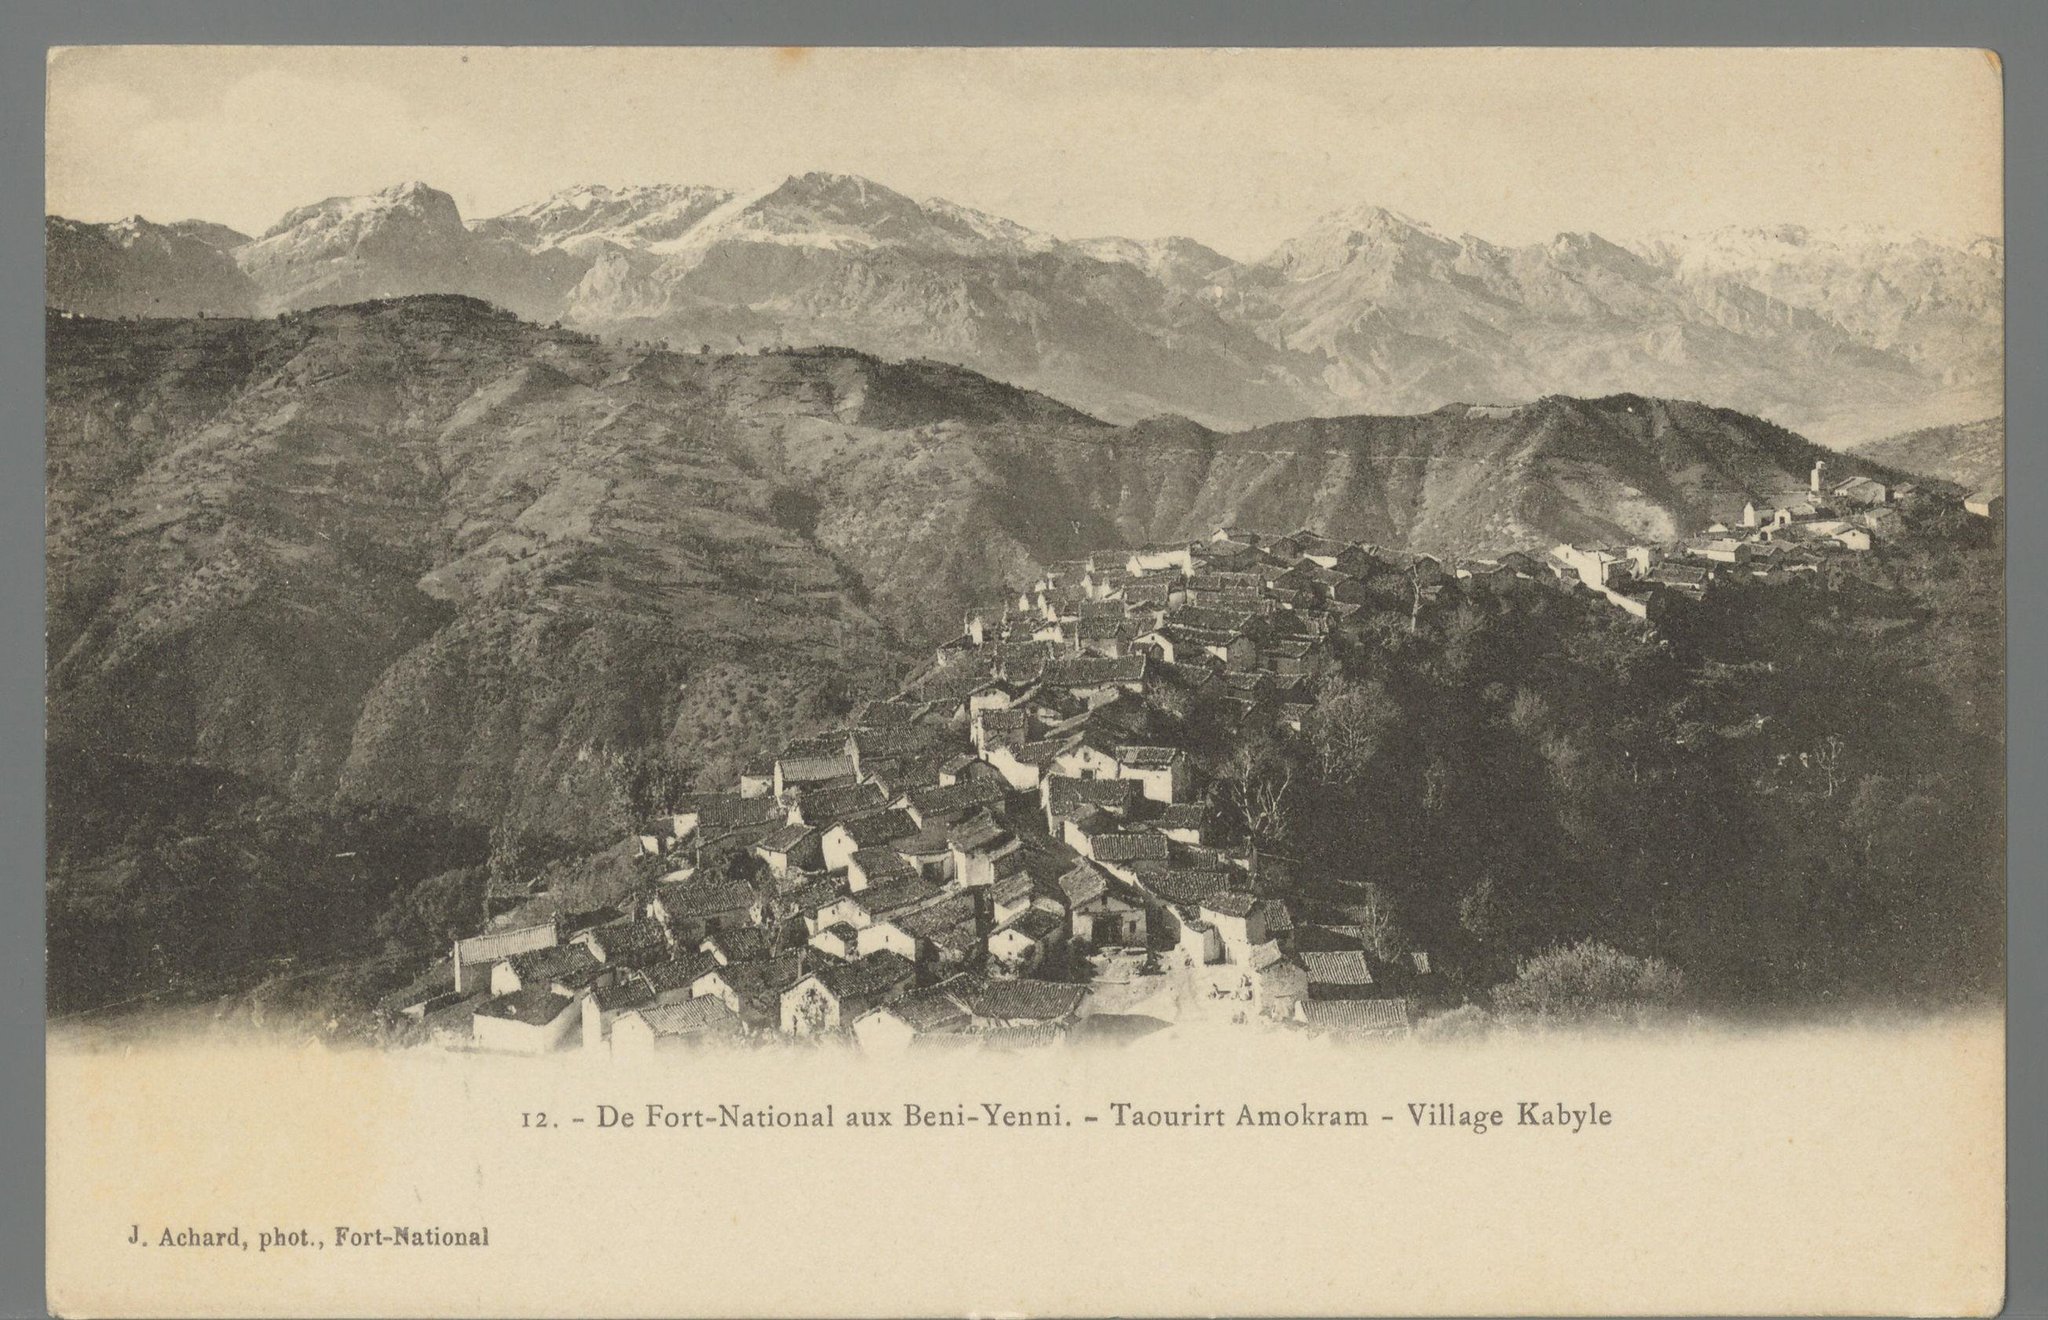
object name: ansichtkaart, prentbriefkaart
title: De Fort-National aux Beni-Yenni. Taourirt Amokram. Village Kabyle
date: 1903-1904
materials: cardboard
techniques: photograph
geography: algeria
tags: prospect of village, silhouette of village, mountain-range, snow peaks